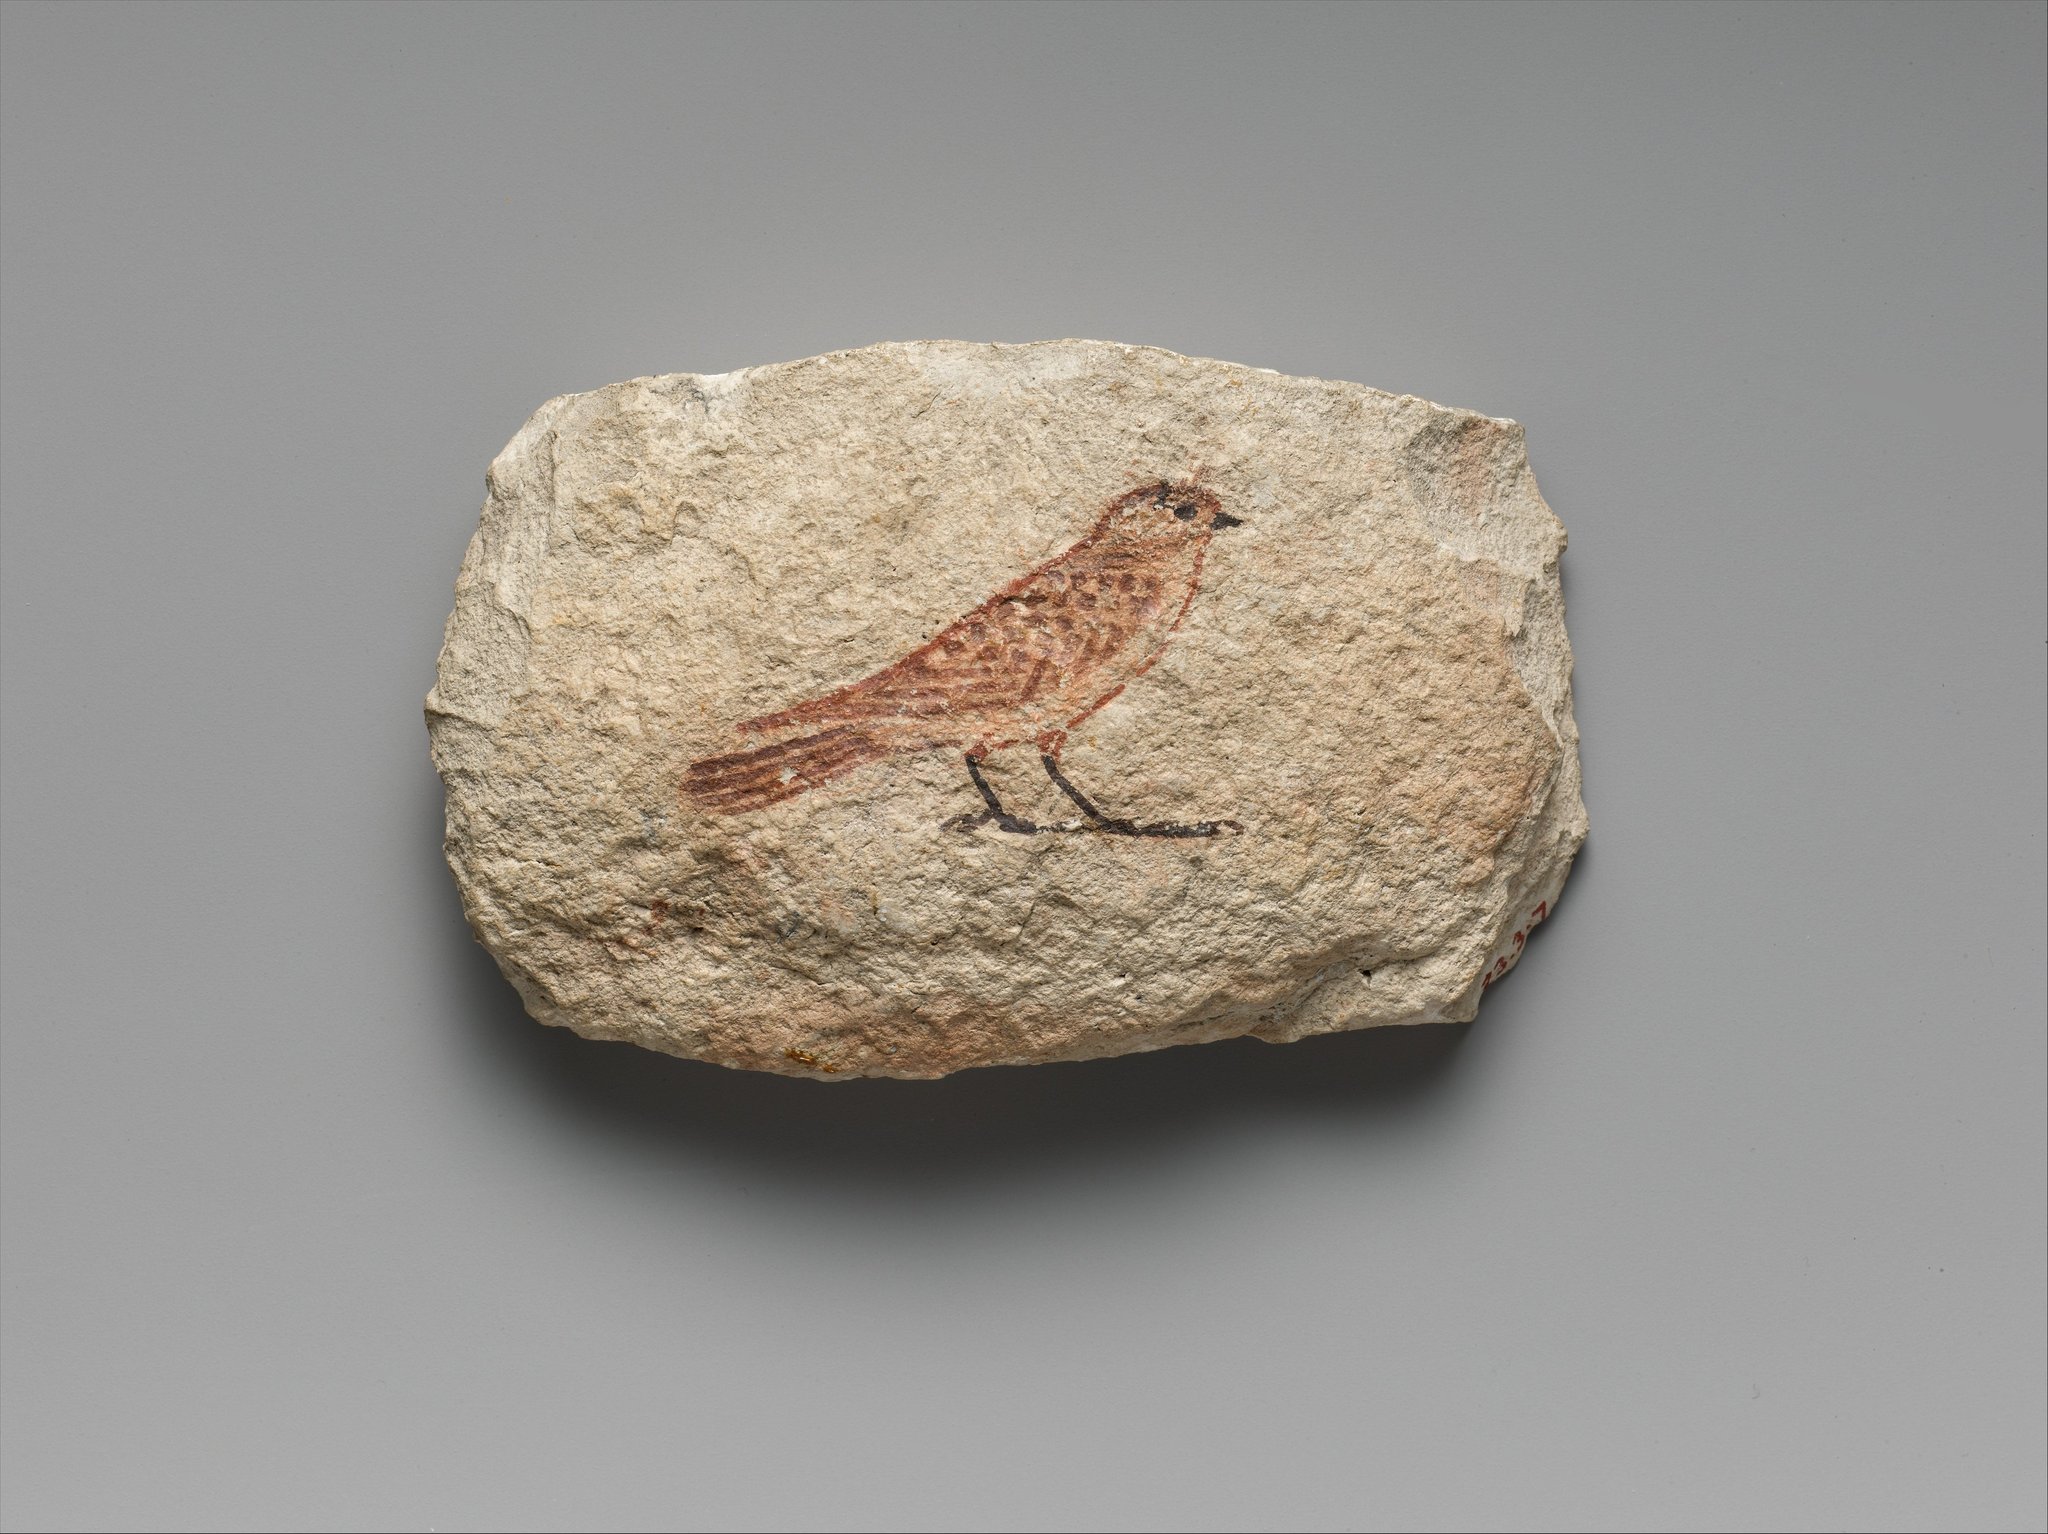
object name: ostracon, hieroglyph, sparrow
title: Artist's Sketch of a Sparrow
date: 1479-1458 BCE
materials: limestone, paint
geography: egypt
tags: birds